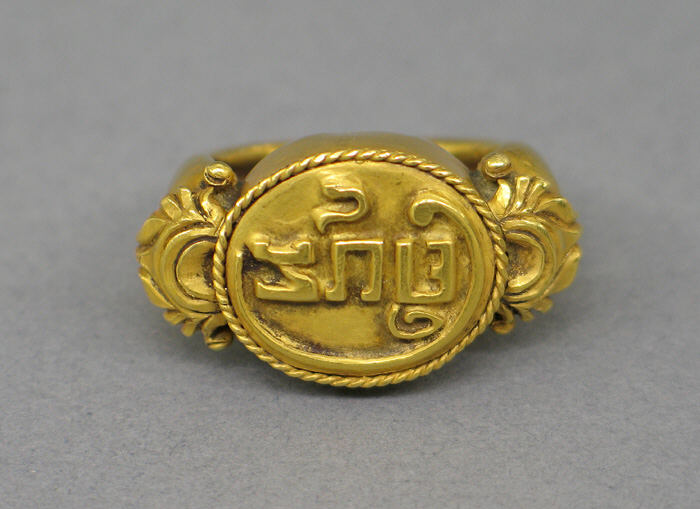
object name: ring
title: Ring with Oval Bezel with Java Kuno Raised Inscription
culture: indonesian, javanese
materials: gold